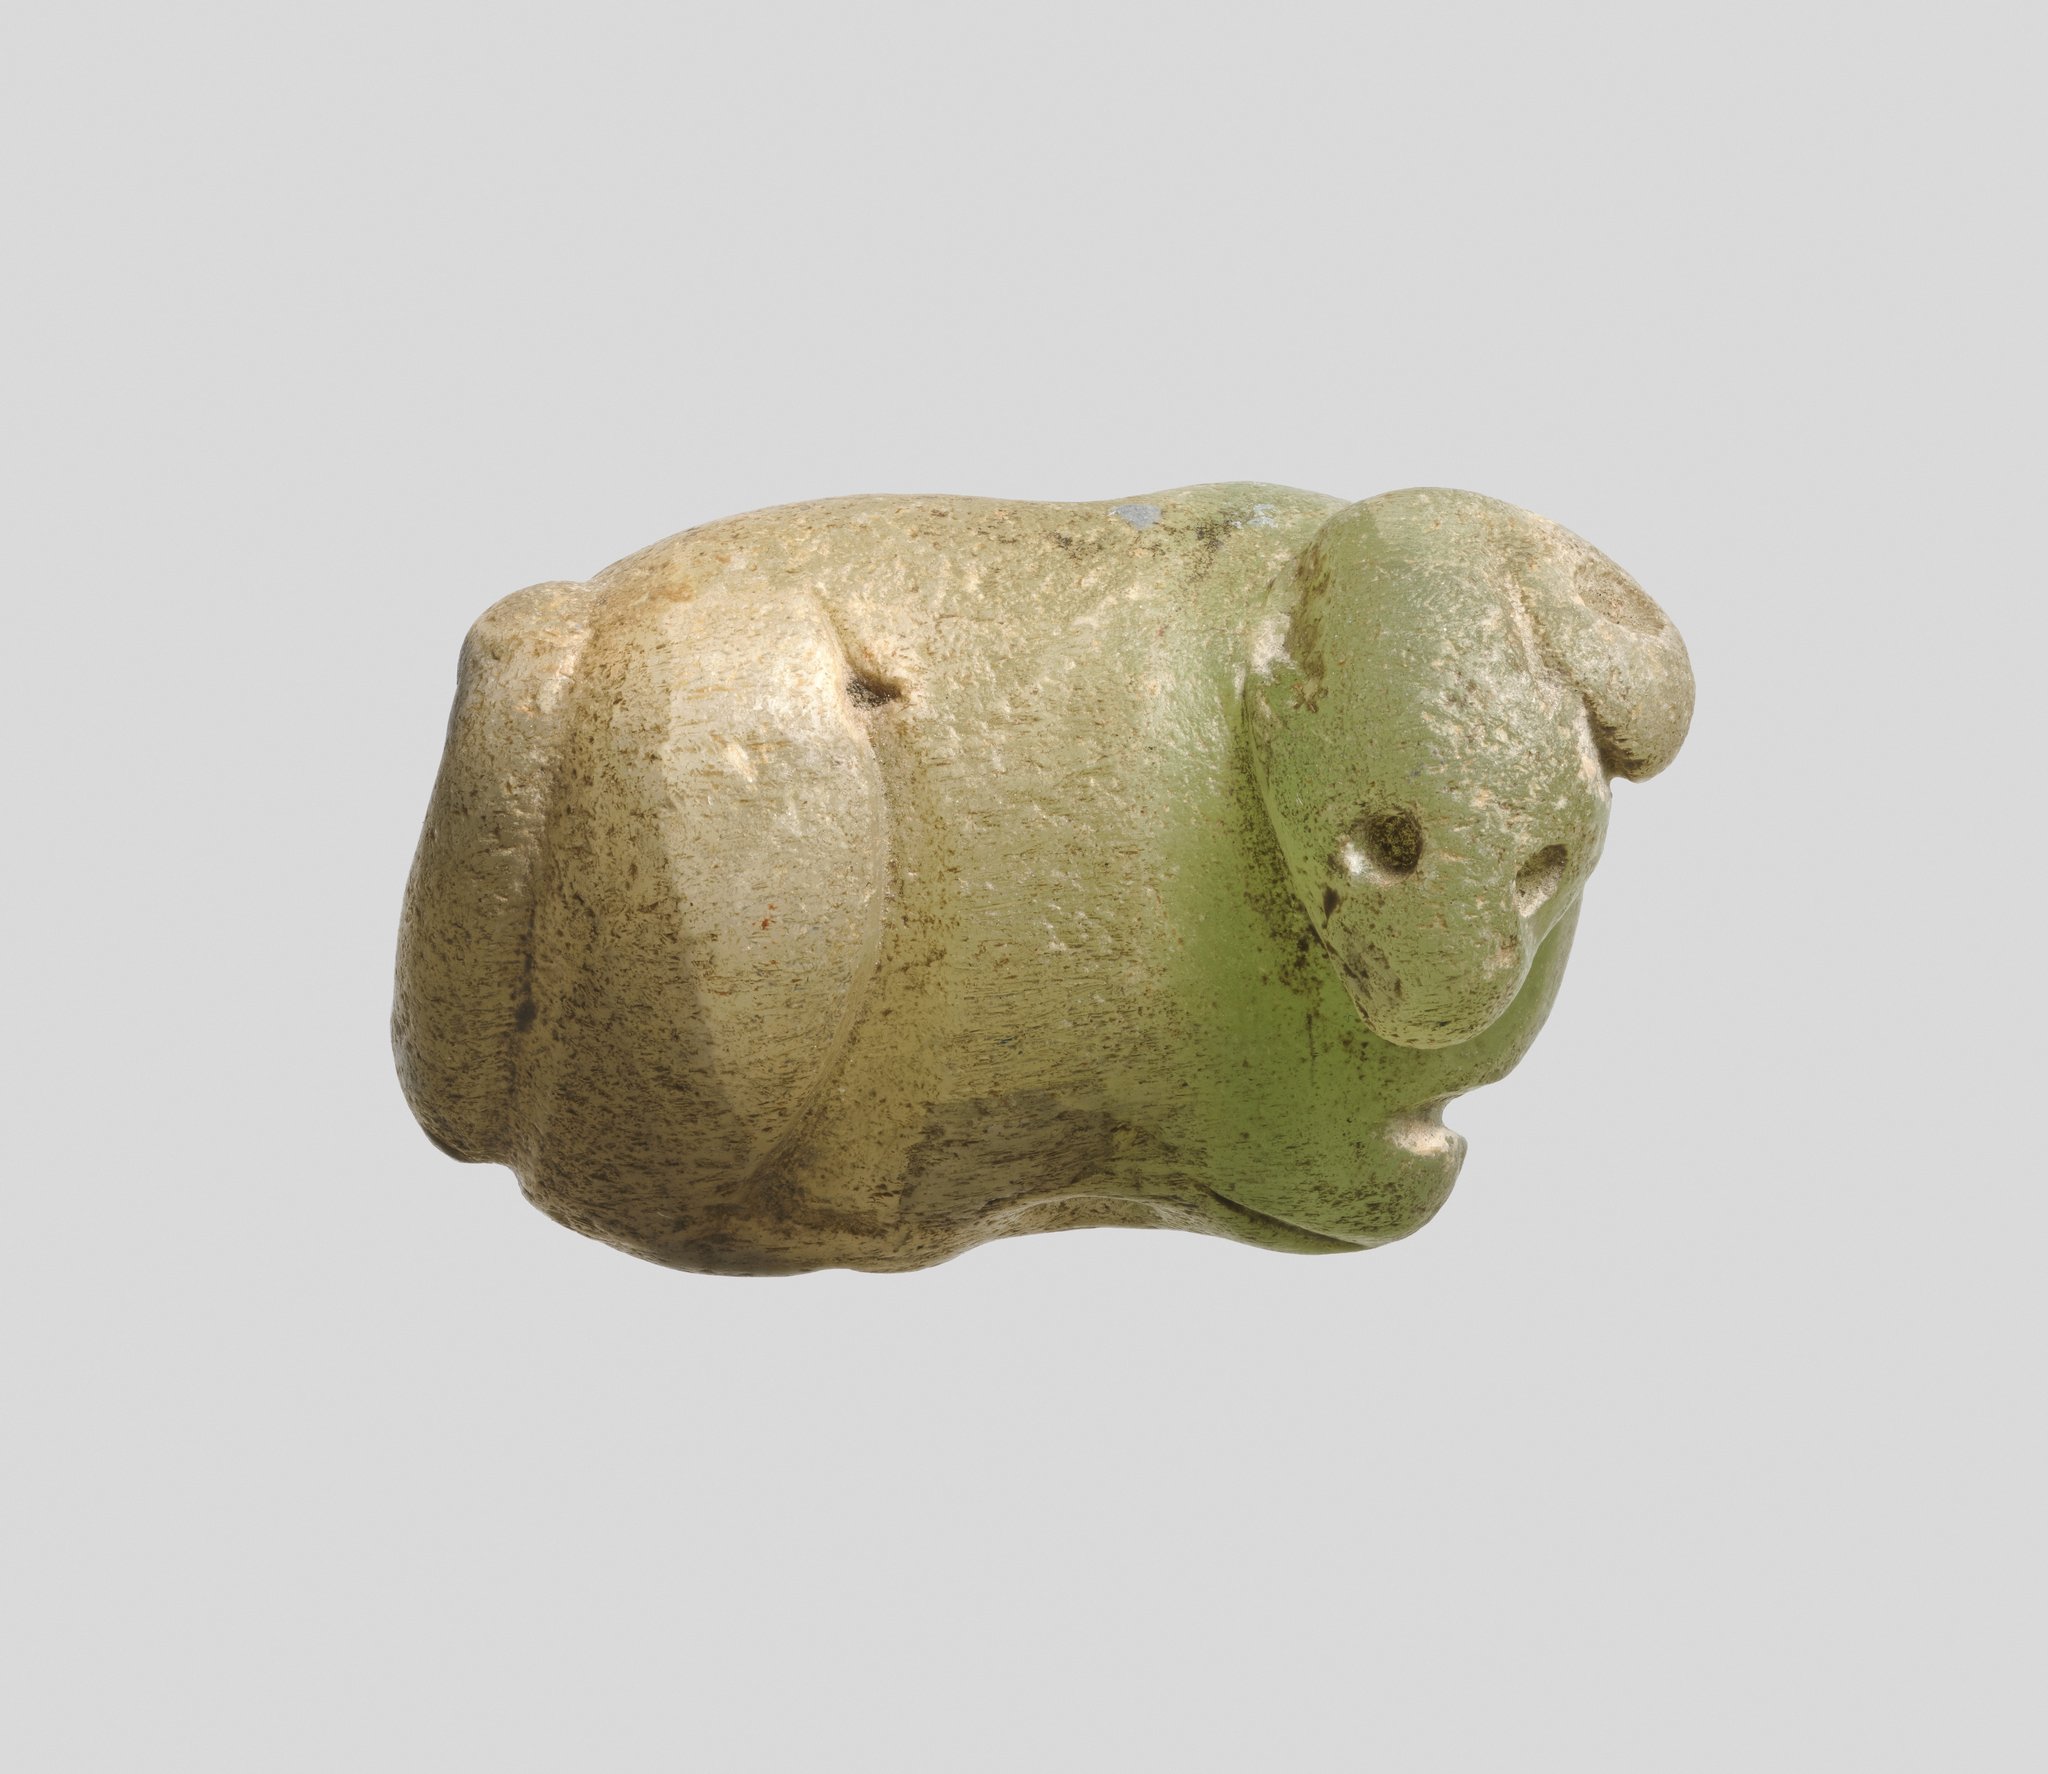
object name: stamp seal amulet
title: Seal amulet in the form of a recumbent bovid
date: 3500-2900 BCE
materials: marble, onyx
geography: iran or mesopotamia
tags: animals